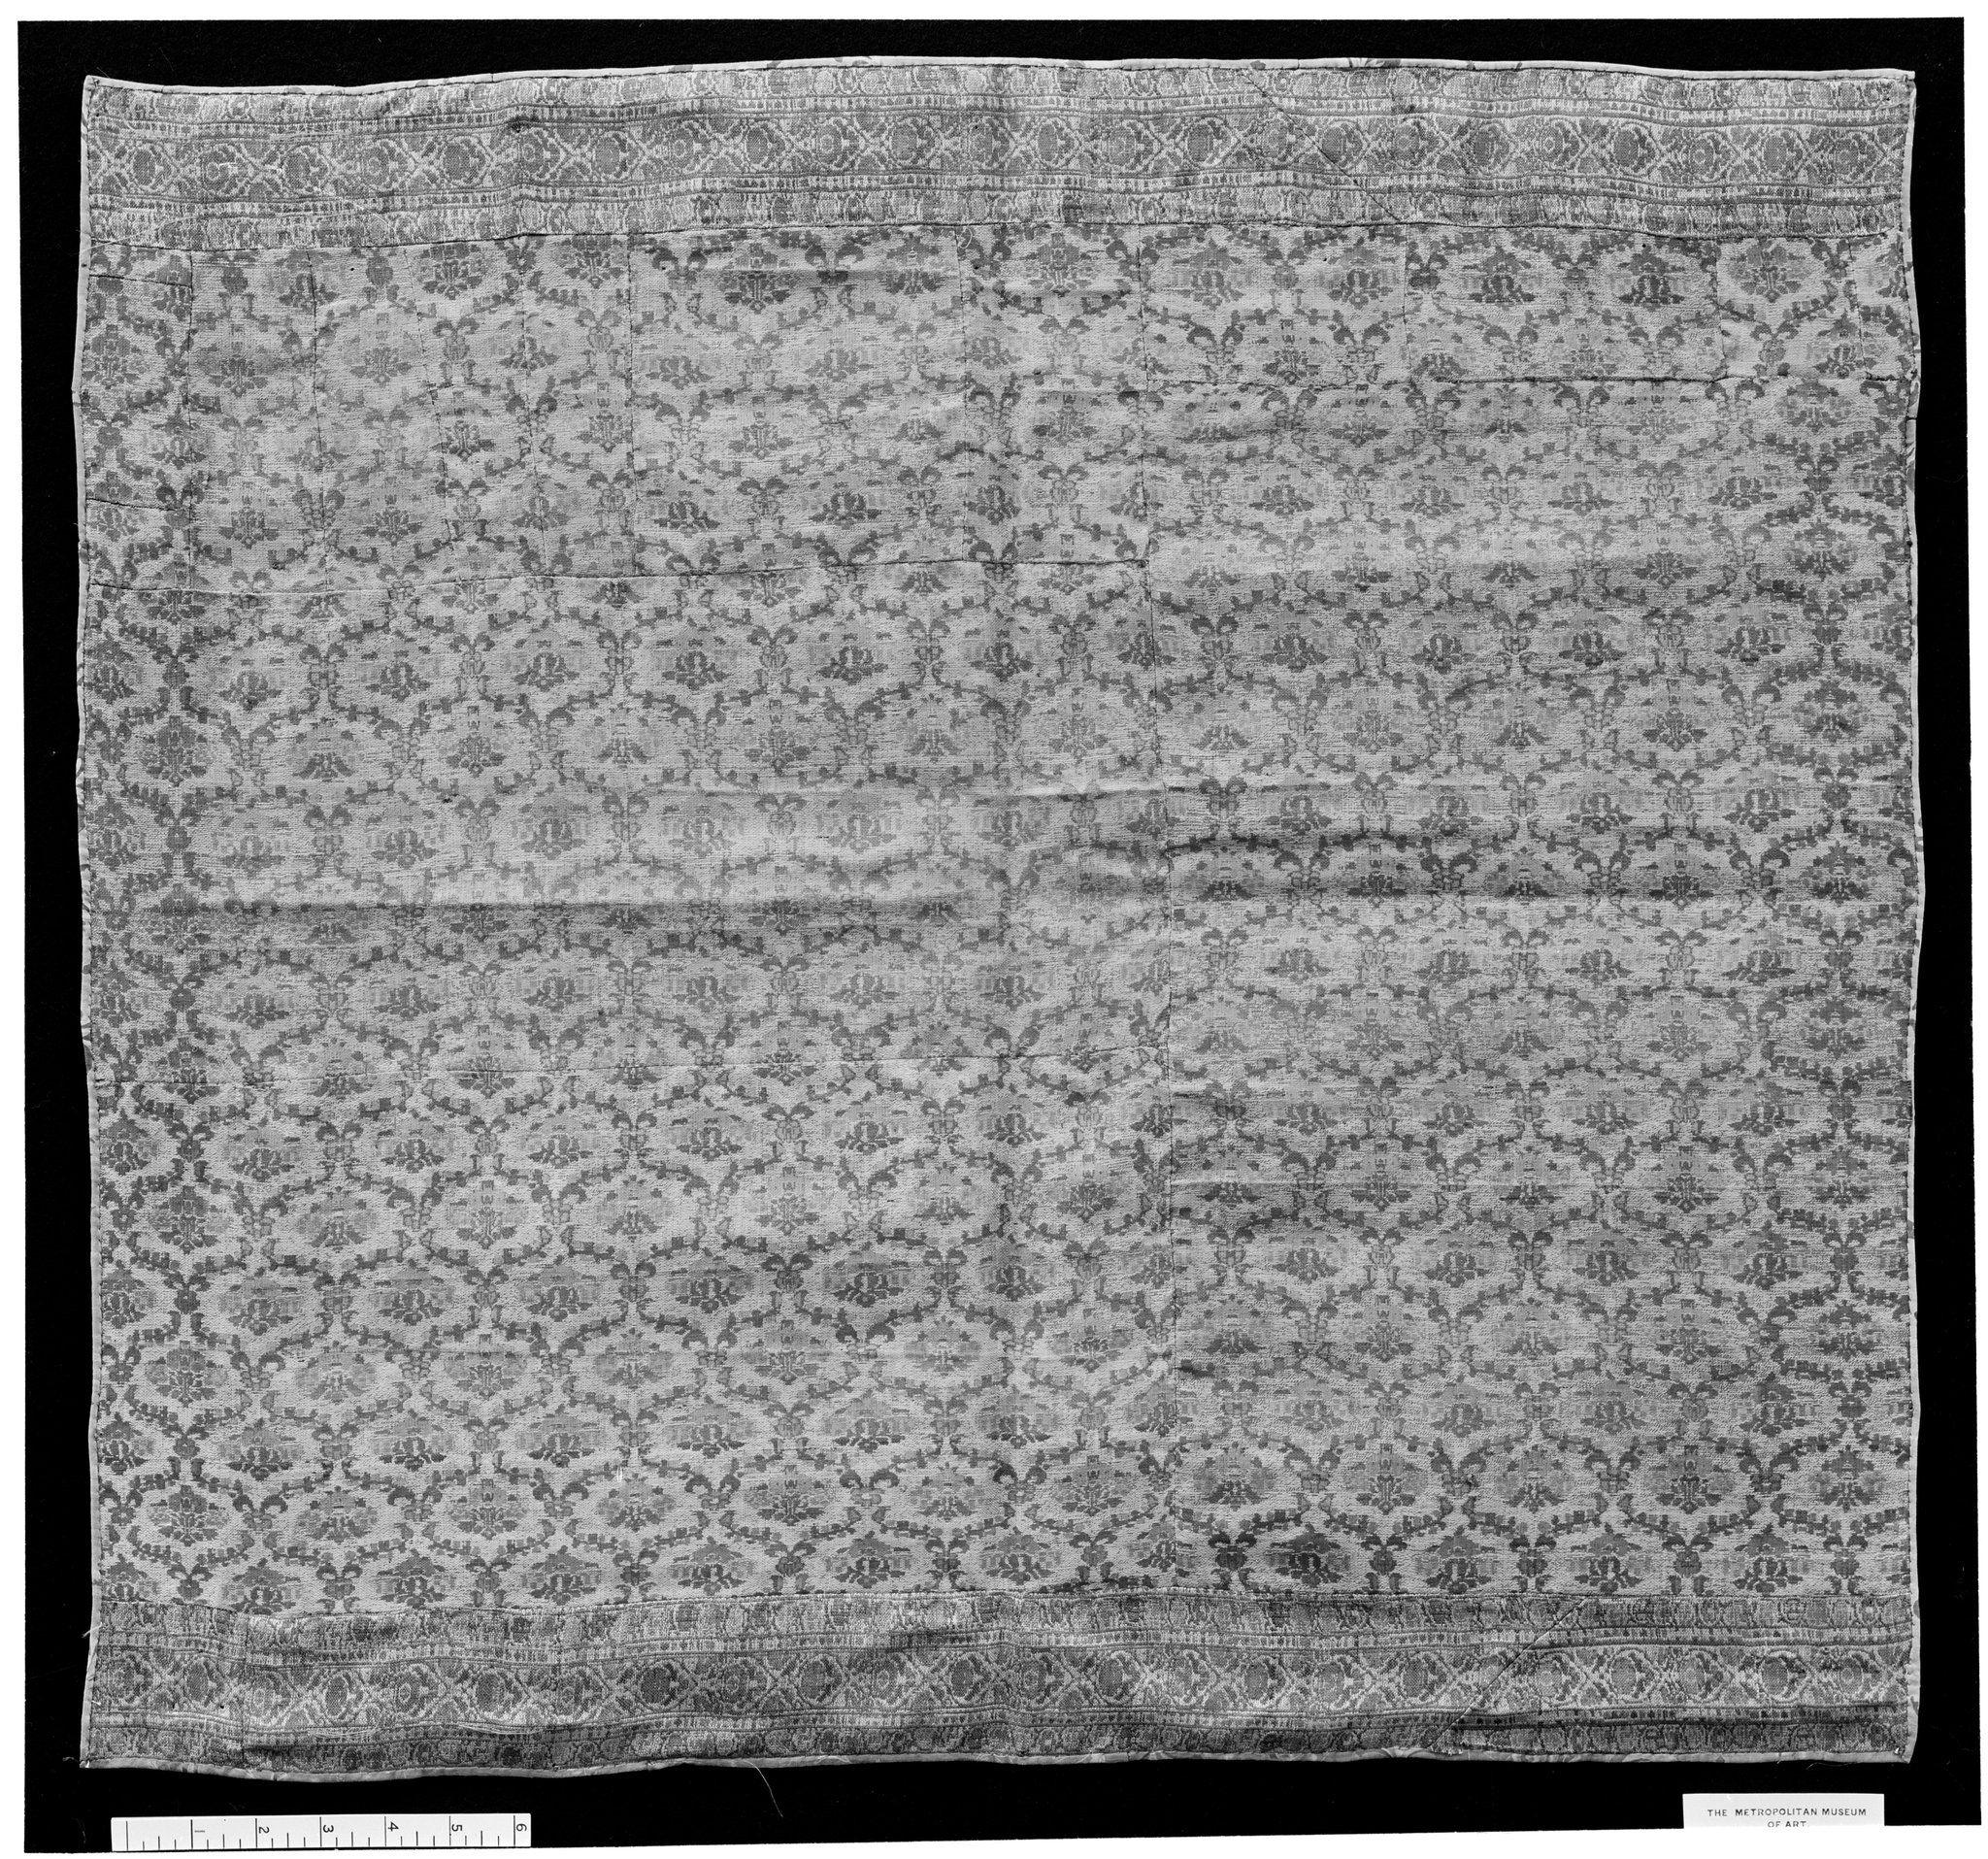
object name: cover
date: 1701-1800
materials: silk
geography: iran